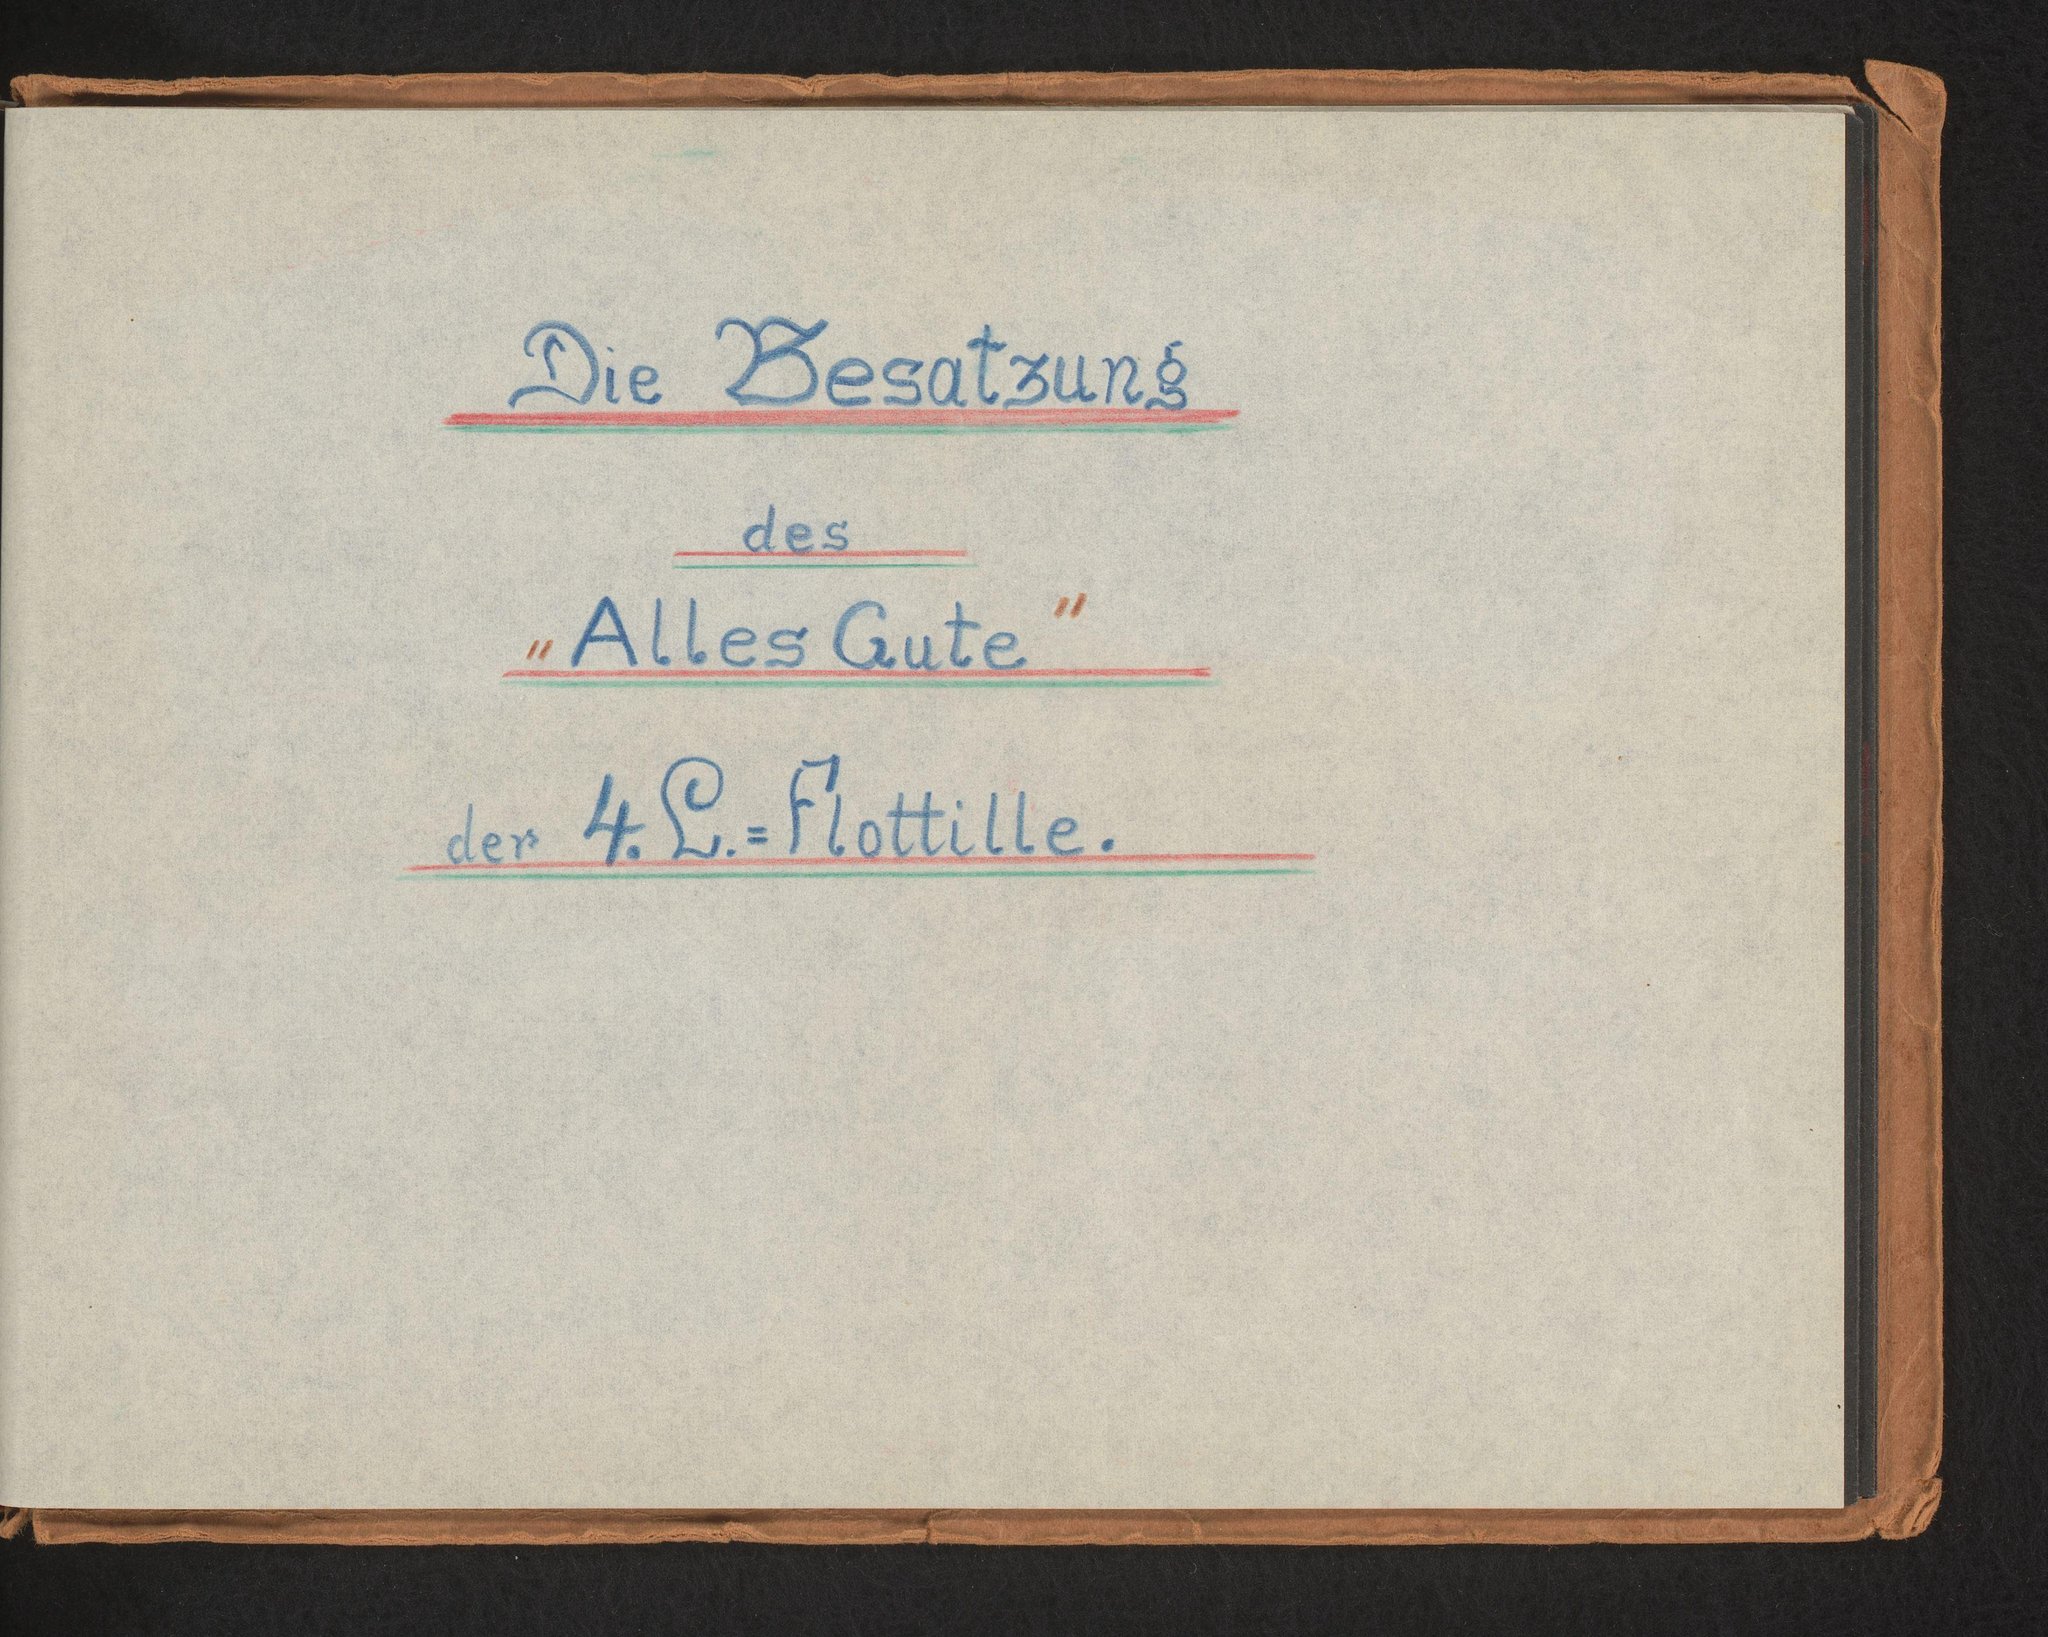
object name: album leaf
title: Die Besatzung des "Alles Gute" der 4.L.-Flotille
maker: werner neufang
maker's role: militair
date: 1943-1944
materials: paper, pencil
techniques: writing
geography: germany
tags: werner neufang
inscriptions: inscription: ‘Die Besatzung des "Alles Gute" der 4.L.-Flotille’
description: Blad met een handgeschreven tekst. Tussenblad tussen bladzijde 26 en 27. Onderdeel van een fotoalbum over de Duitse Werner Neufang van de Kriegsmarine en de Nederlandse Thea Driesen.